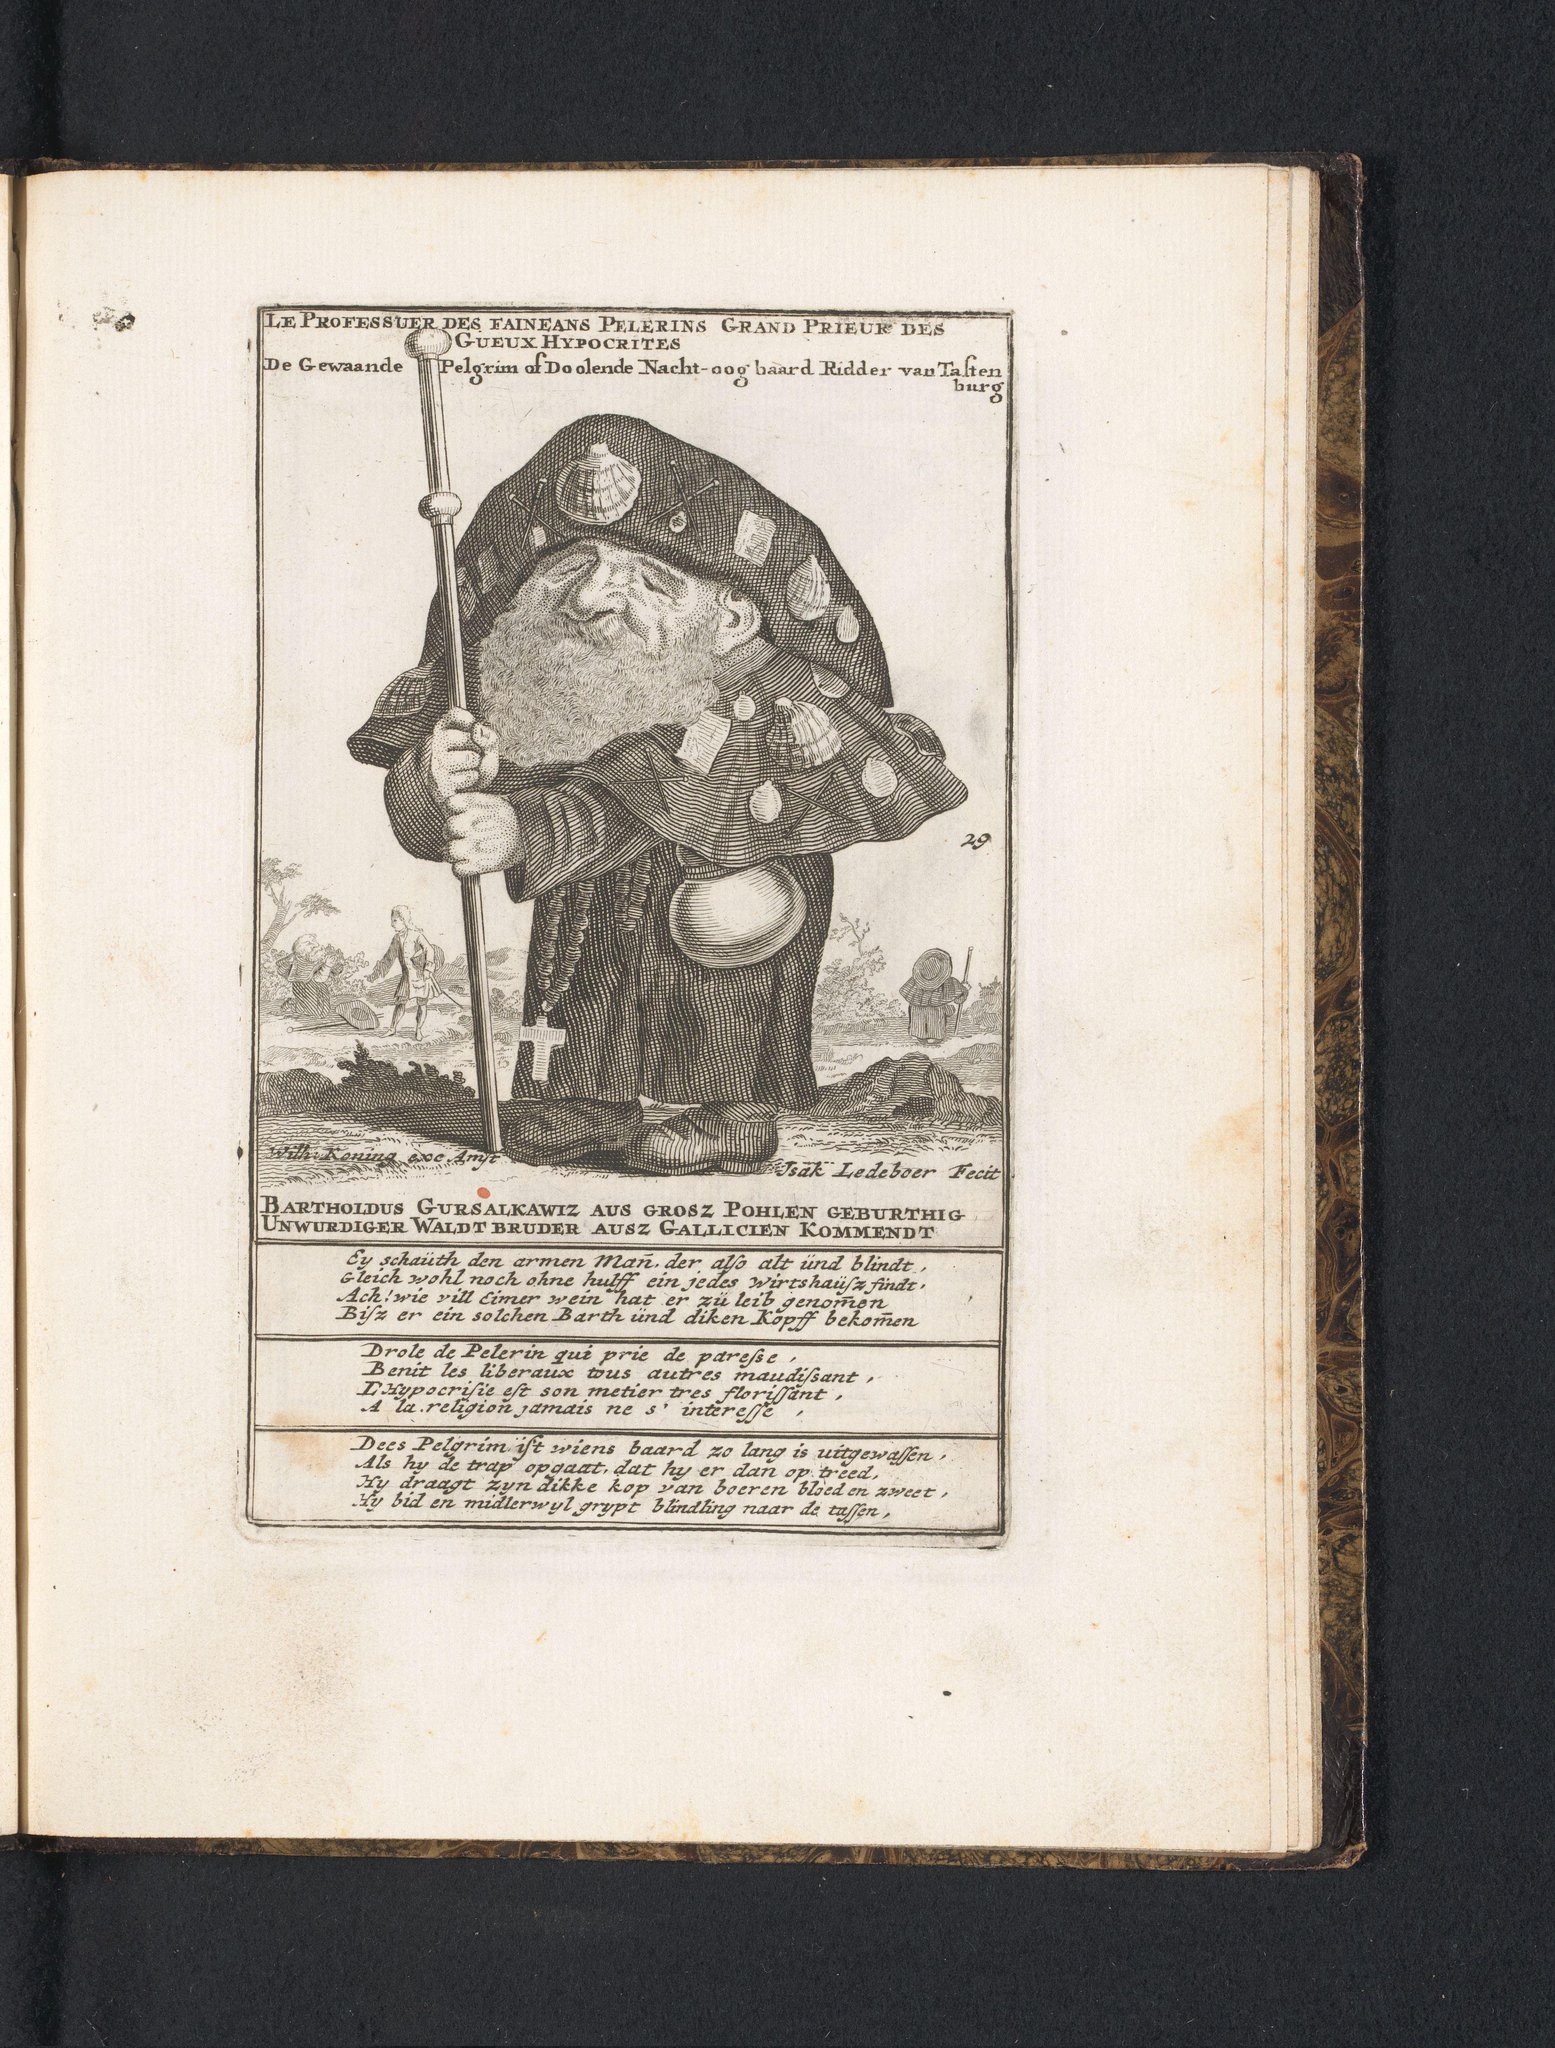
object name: print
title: Le Professuer Fainfans Pelerins grand prieur des Gueux Hypocrites / De Gewaande Pelgrim of Doolende Nacht-oog baard Ridder van Tastenburg / Bartholdus Gursalkawiz aus grosz Pohlen geburthig, Unwurdiger Waldtbruder ausz Gallicien kommendt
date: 1718-1720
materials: paper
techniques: etching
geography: amsterdam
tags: caricatures (human types), return from pilgrimage, little people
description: De Poolse kleine mens Gewaande Pelgrim als pelgrim terugkerend uit Santiago de Compostella. In het onderschrift verzen in het Duits, Frans en Nederlands. Genummerd rechts midden: 29. Onderdeel van deel II in de tweede Nederlandse gebonden uitgave uit 1720 (en gerelateerd aan de Windhandel in dat jaar) van een serie karikaturen van kleine mensen, bekend als Het Dwergentooneel.